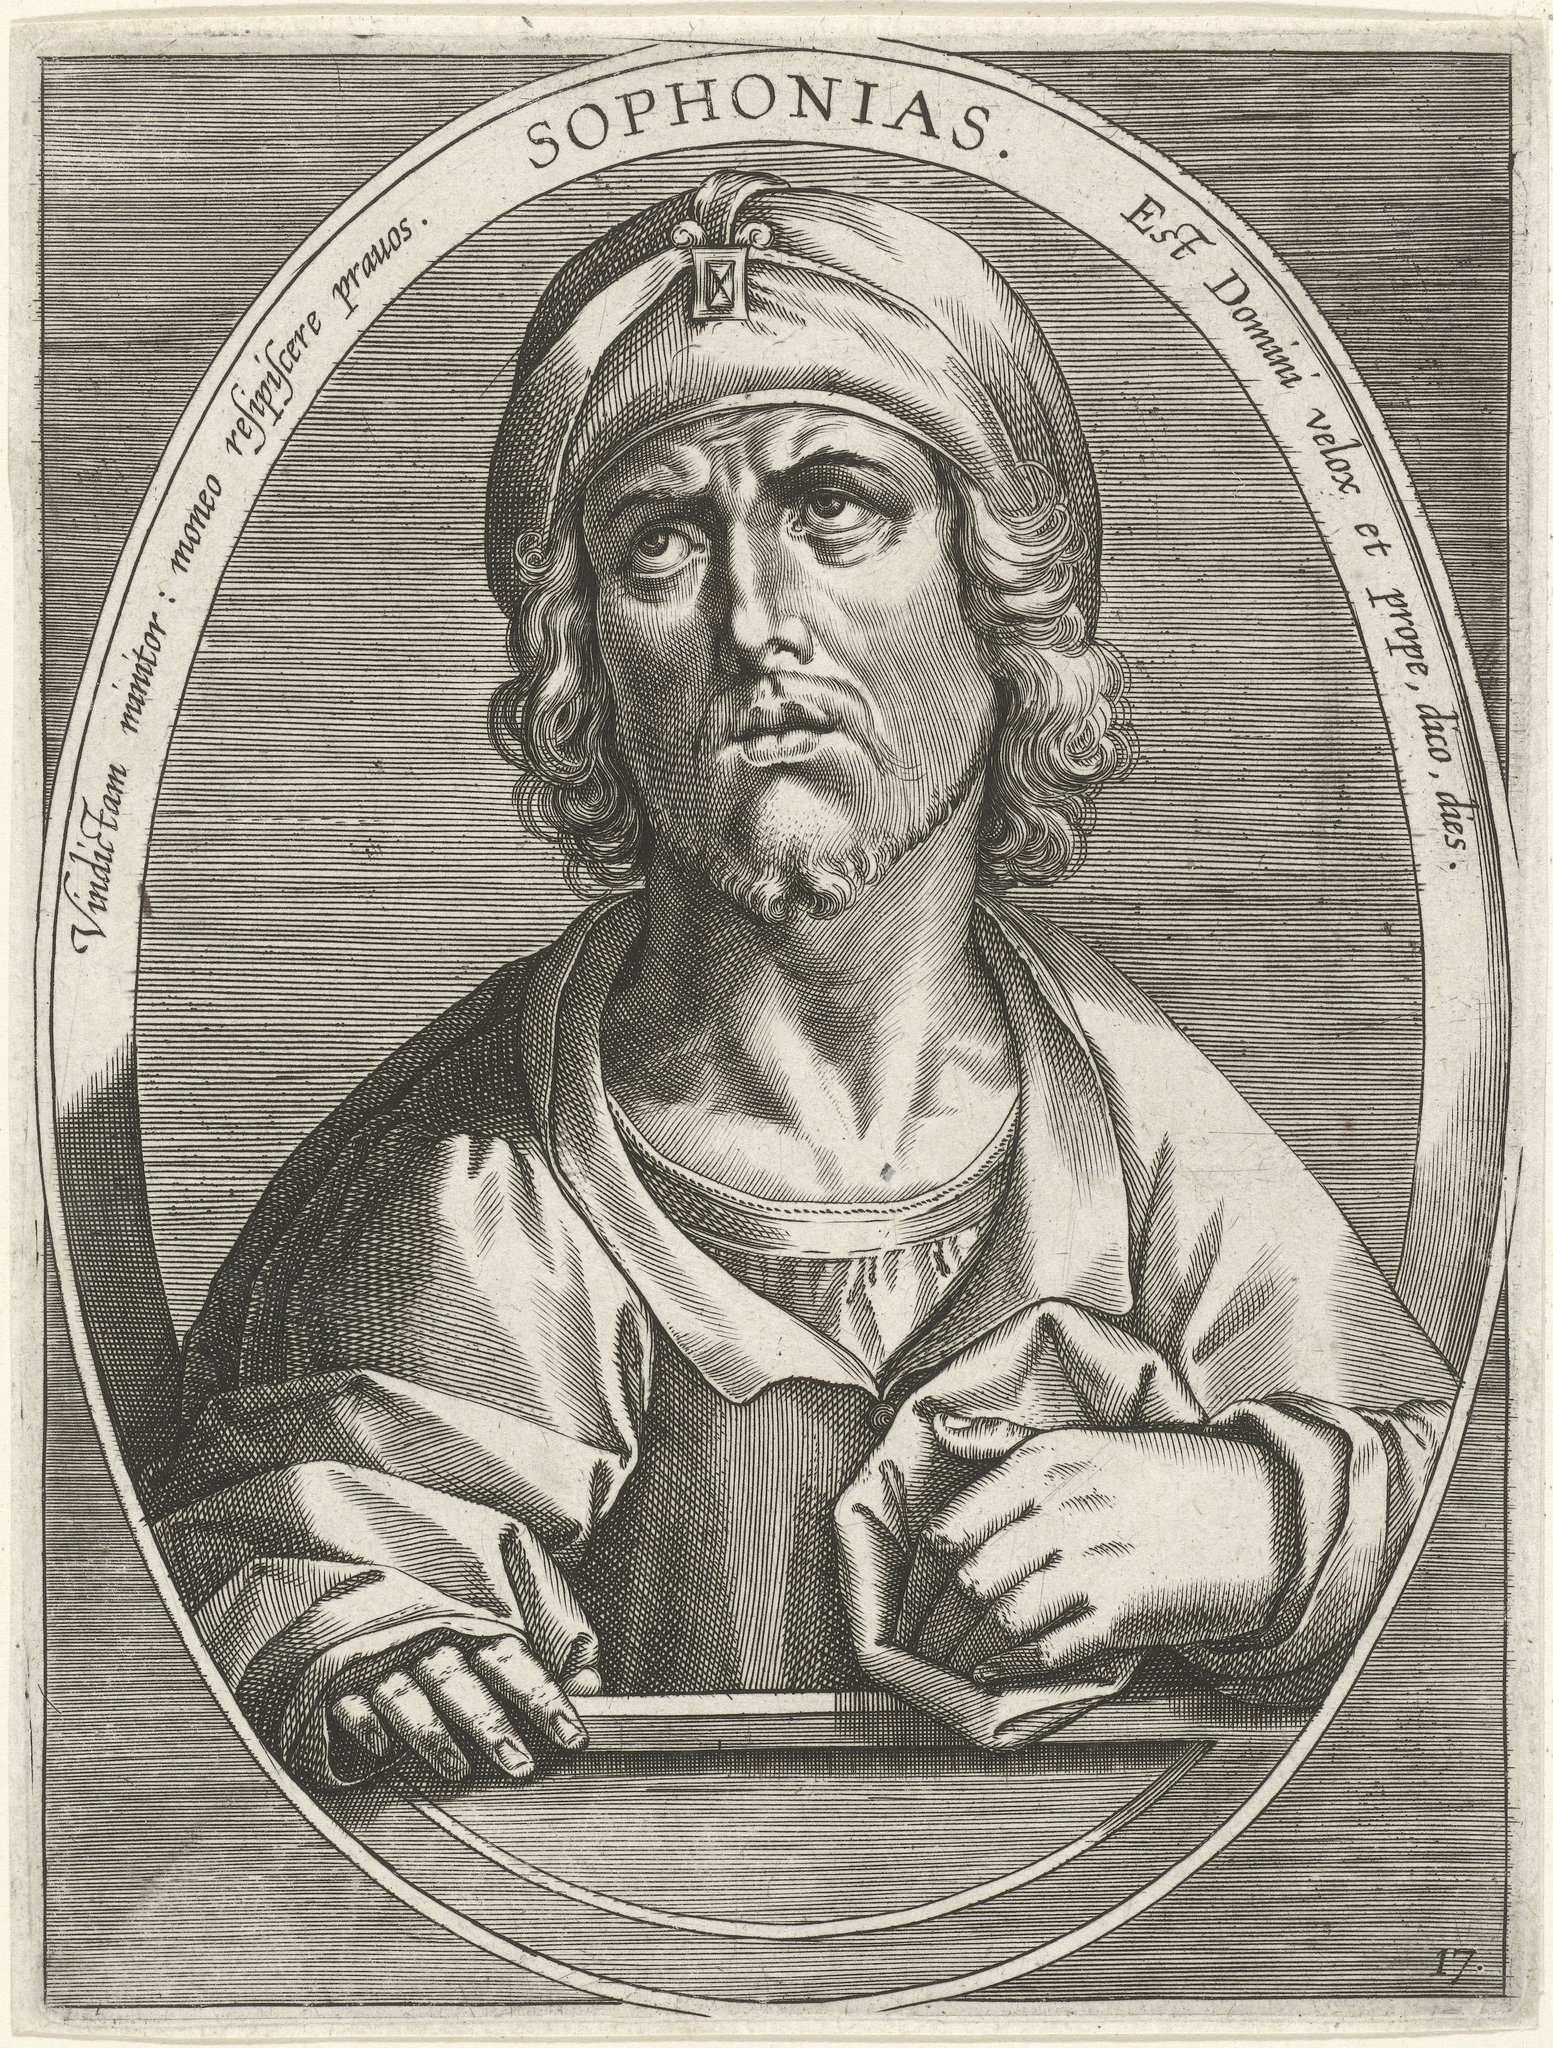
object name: print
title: Icones Prophetarum Veteris Testamenti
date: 1613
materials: paper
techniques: engraving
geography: antwerp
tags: the twelve minor prophets (not in biblical context): hosea, joel, amos, obadiah, jonah, micah, nahum, habakkuk, zephaniah, haggai, zechariah, malachi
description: De profeet Zefanja, in ovaal met Latijns randschrift. Zofanja draagt een tulband.